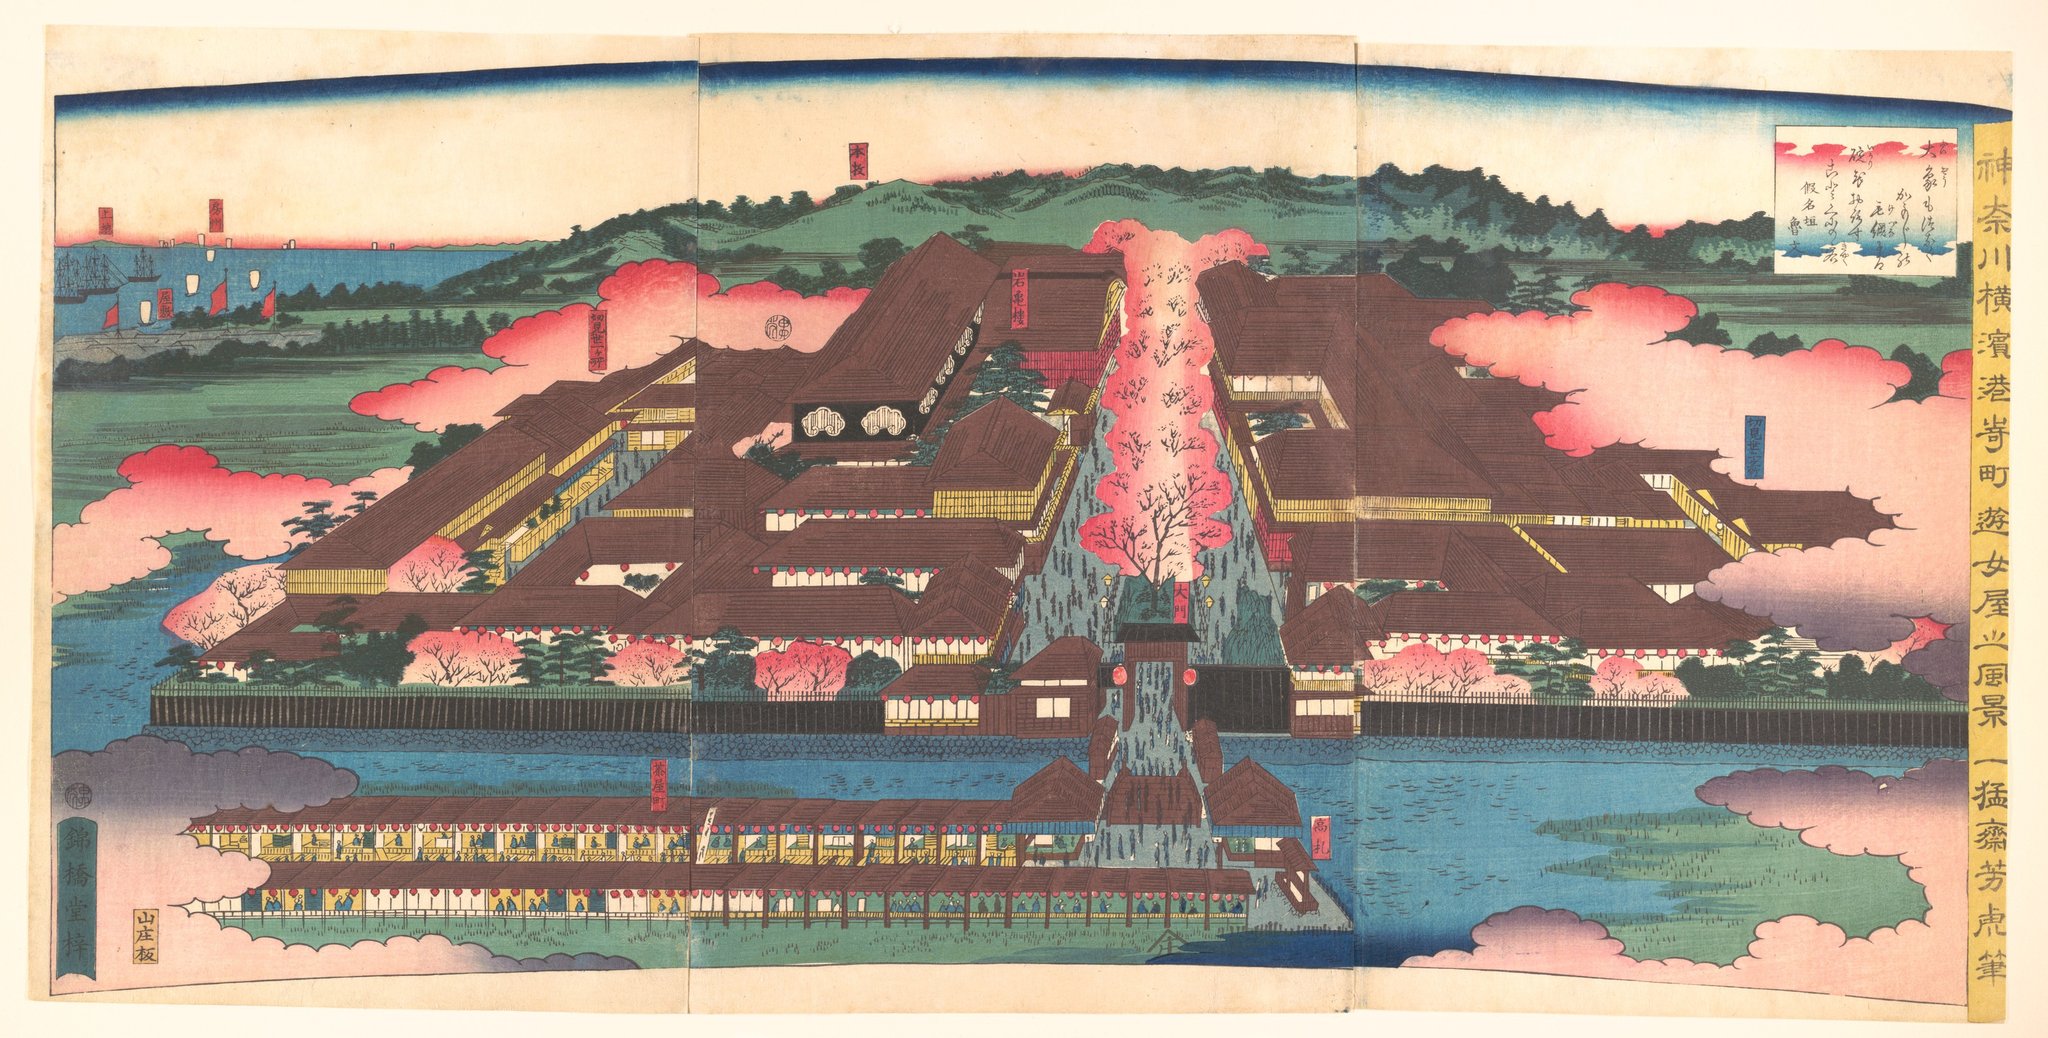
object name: print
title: View of the Miyozaki Brothel District in Yokohama, Kanagawa (Kanagwa Yokohama Miyozaki machi yūjoya kōkei)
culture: japanese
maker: utagawa yoshitora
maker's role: artist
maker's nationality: japanese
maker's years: 1845-1880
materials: ink, paper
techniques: woodblock print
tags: buildings